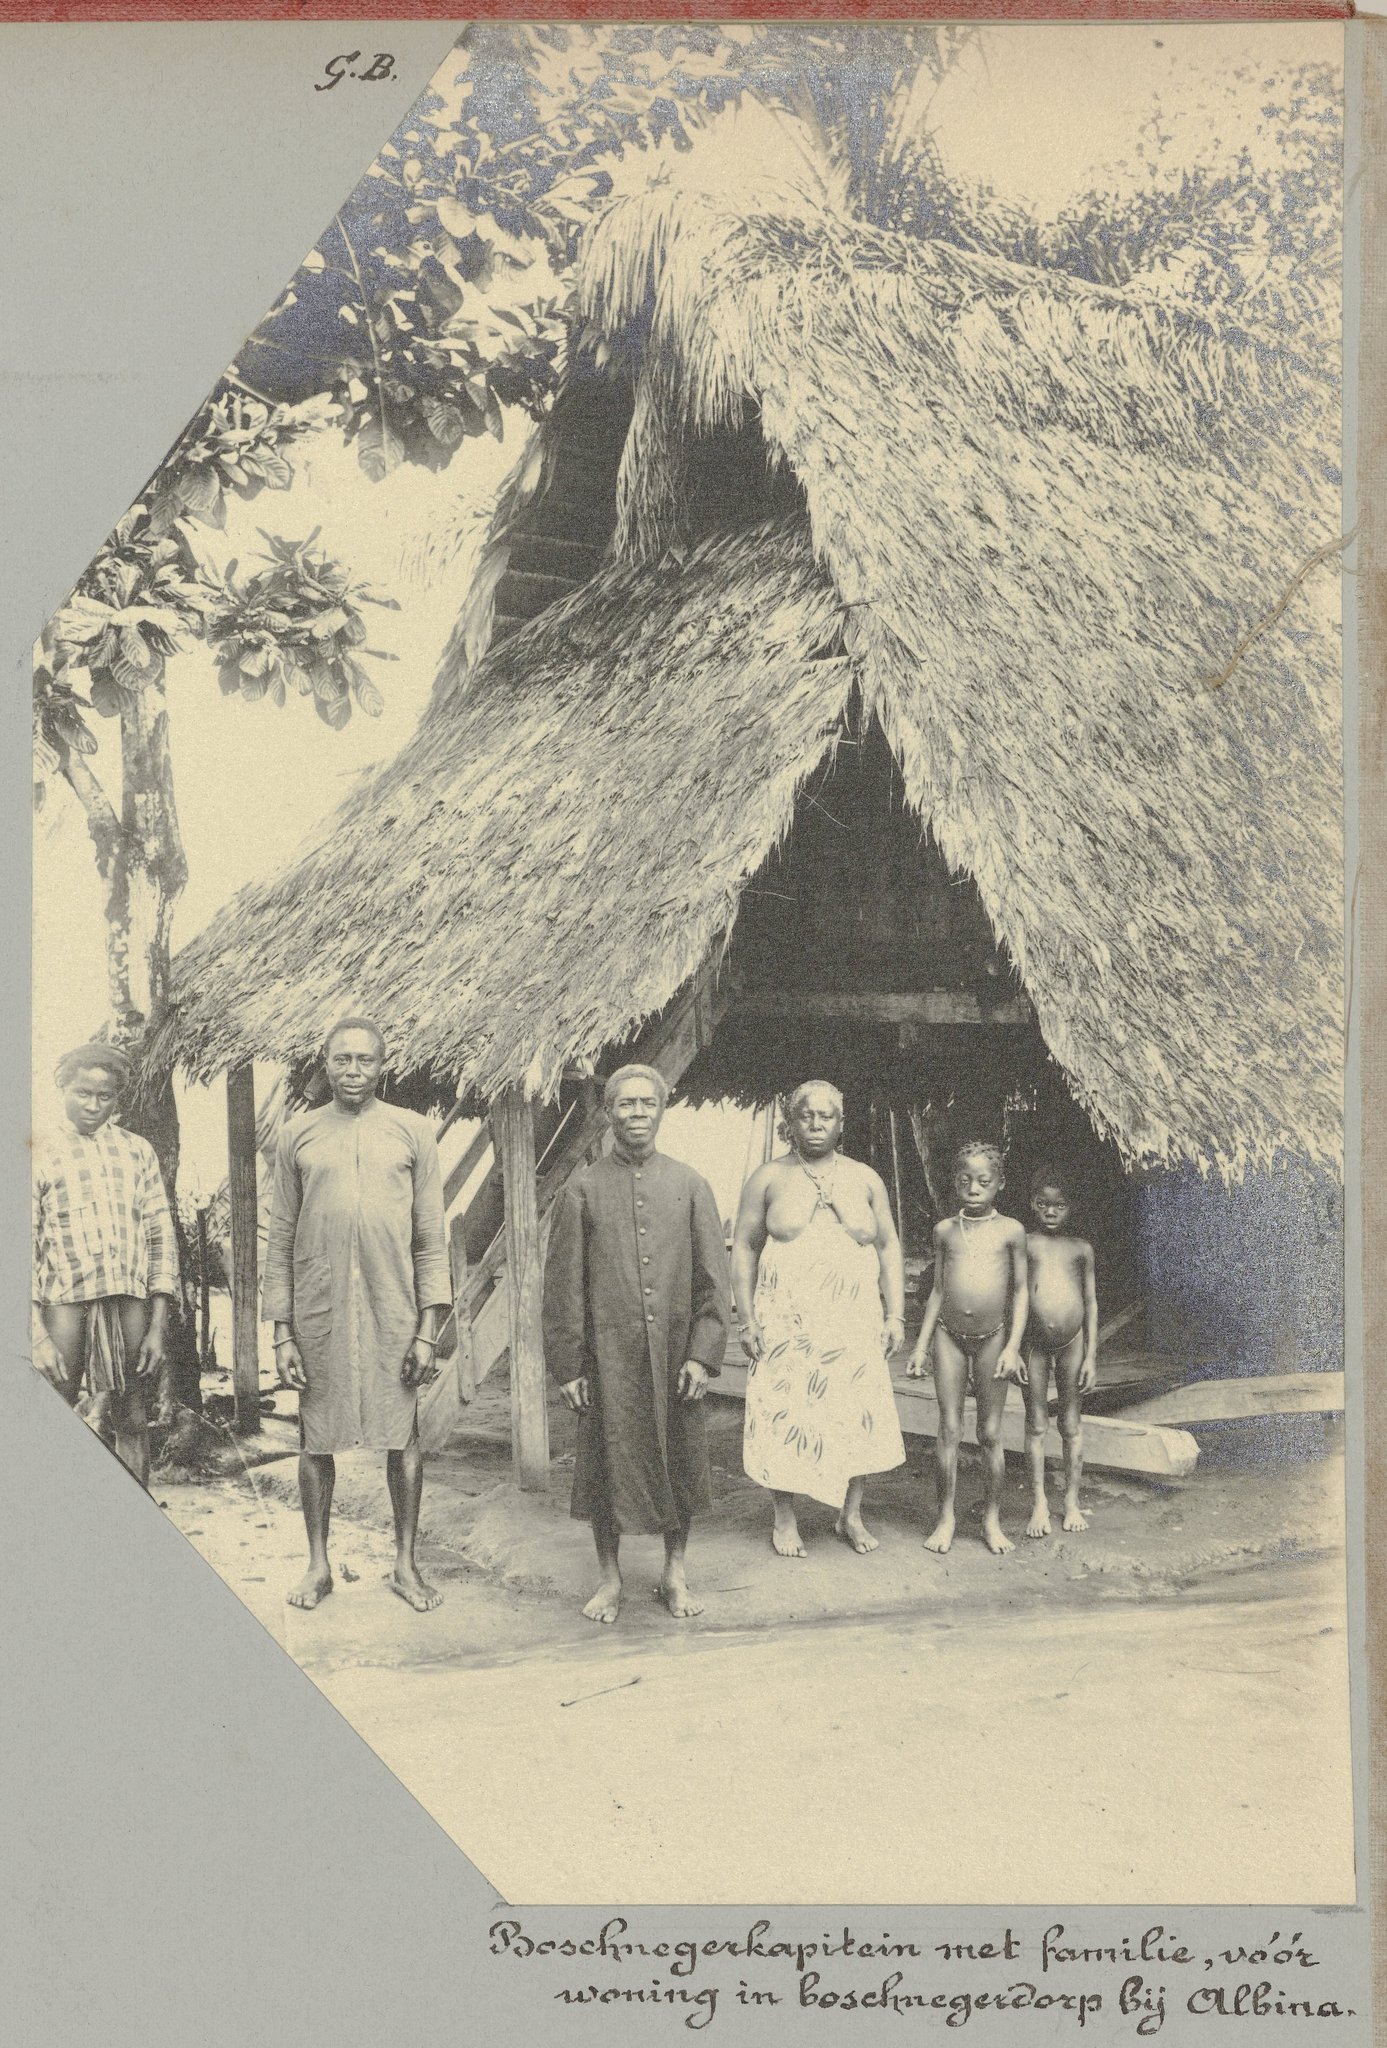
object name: photograph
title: Marronkapitein met familie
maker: gomez burke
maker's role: fotograaf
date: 1891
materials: photographic support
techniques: gelatin silver print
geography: suriname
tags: suriname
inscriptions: inscription: ‘G.B. / Boschnegerkapitein met familie, vóór woning in boschnegerdorp bij Albina.’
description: Portret van een Marronkapitein met zijn familie staande voor hun woning bij Albina. Onderdeel van het fotoalbum Souvenir de Voyage (deel 4), over het leven van de familie Dooyer in en rond de plantage Ma Retraite in Suriname in de jaren 1906-1913.